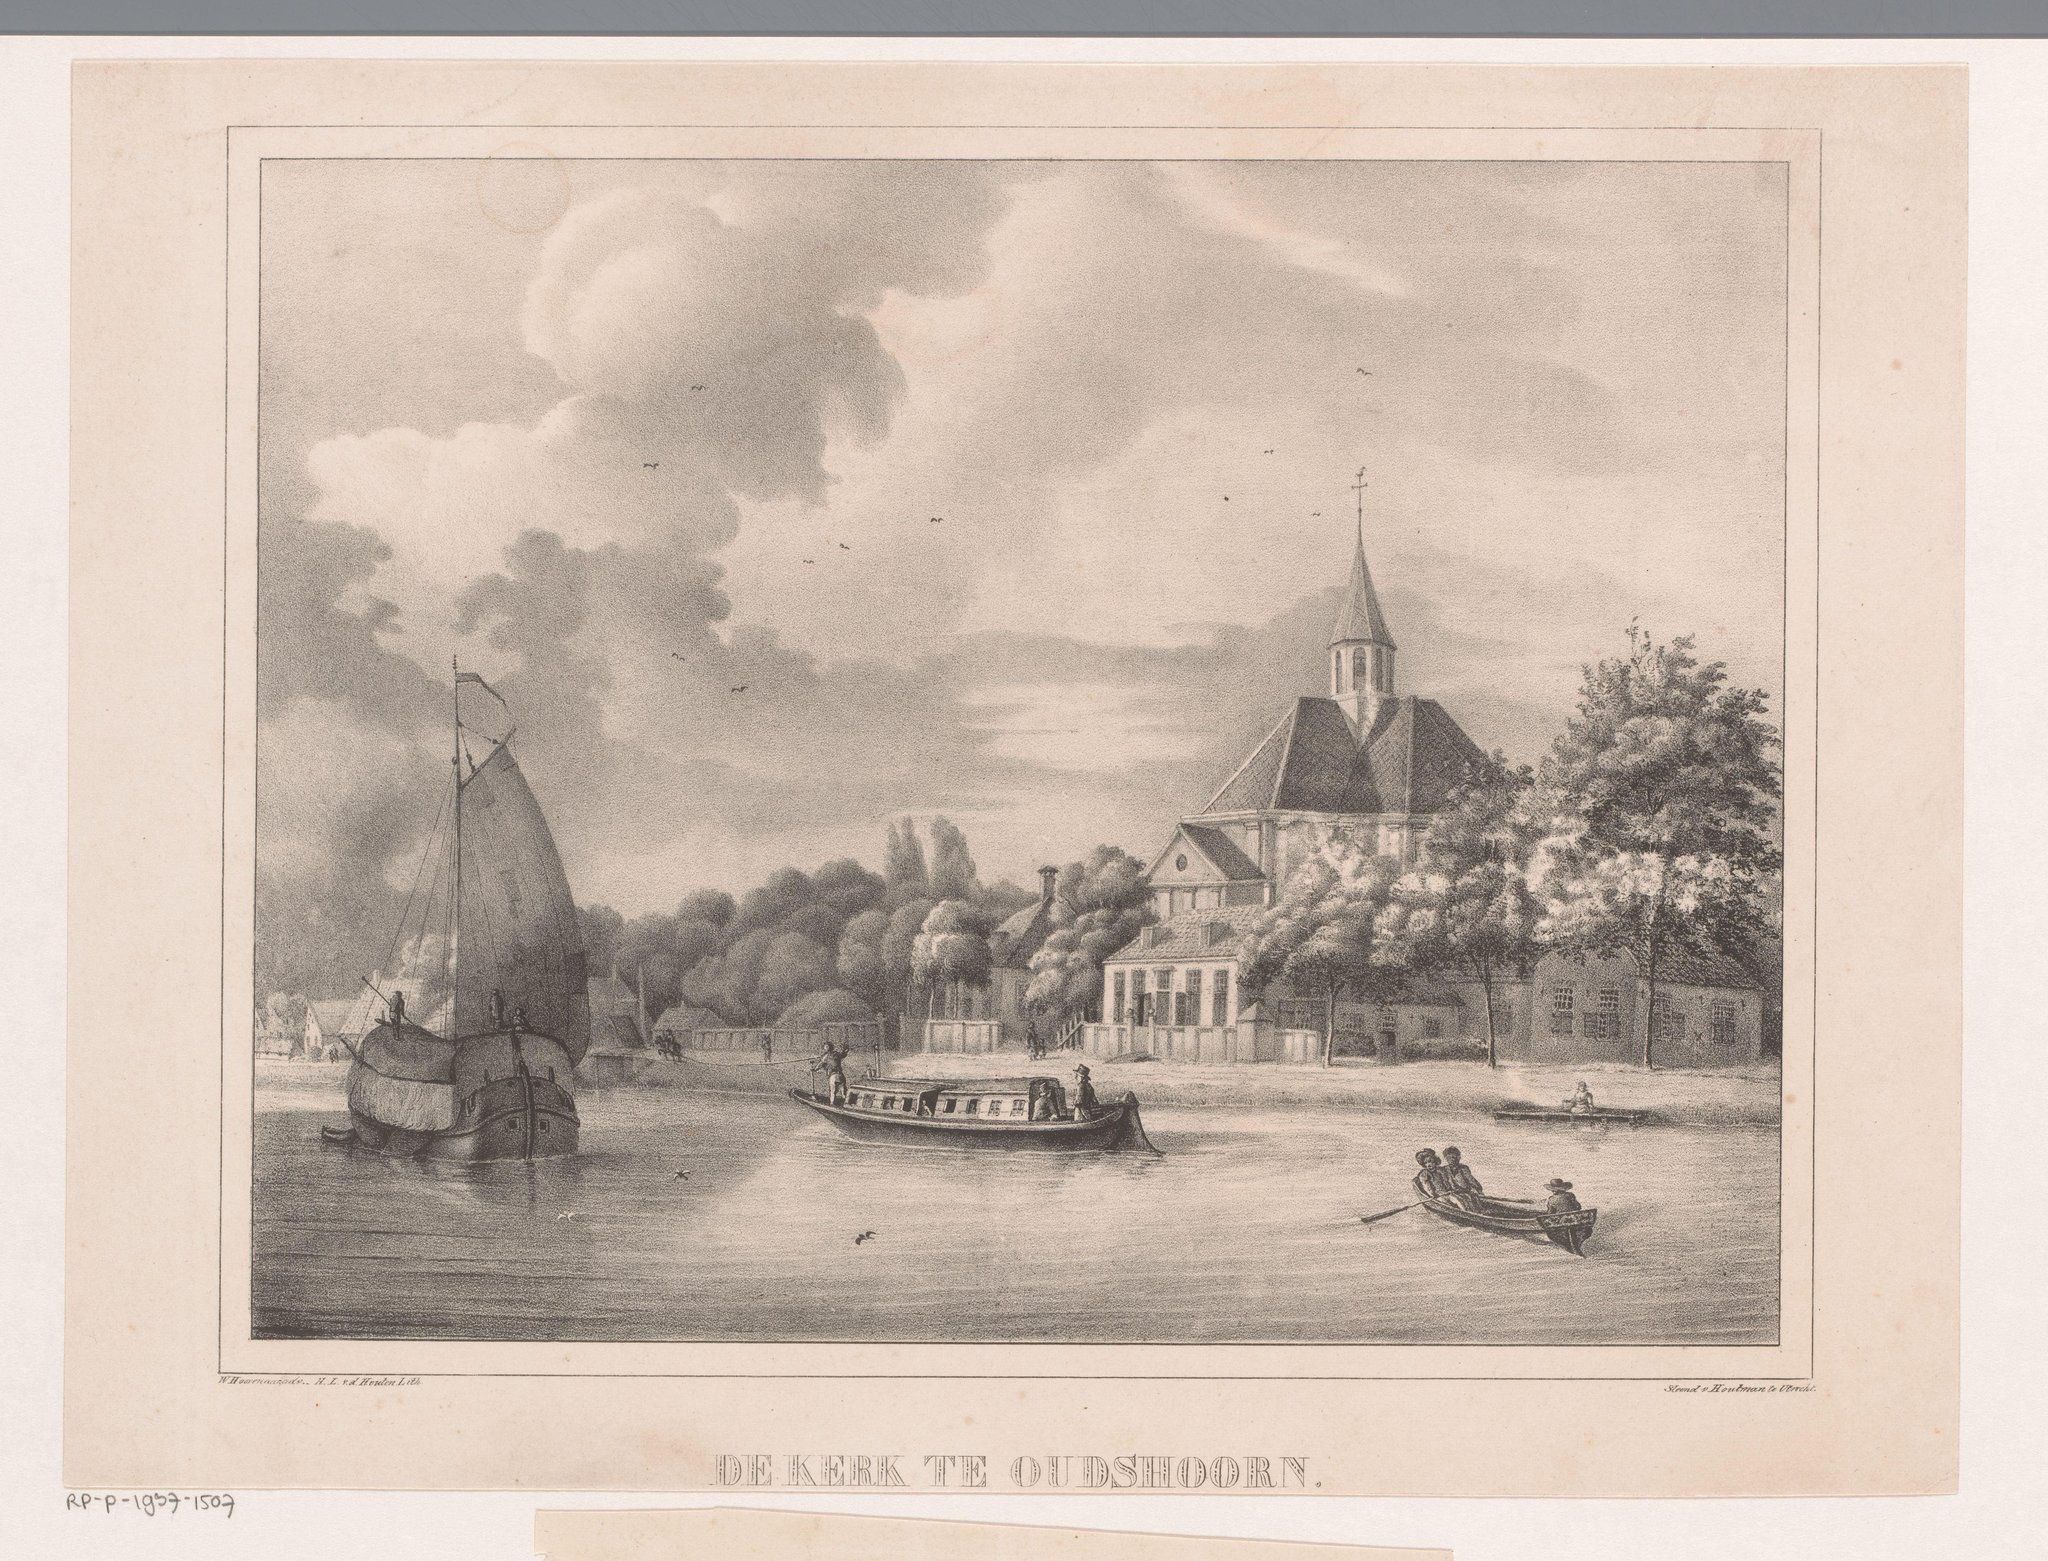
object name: print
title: De Kerk te Oudshoorn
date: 1828-1843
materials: paper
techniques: lithograph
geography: utrecht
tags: sailing-ship, sailing-boat, church (exterior), rowing facing backward, pulling, tow-boat, towing-barge, river (+ landscape with figures, staffage)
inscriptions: collector's mark: Lugt 2228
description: Op het water varen een trekschuit, een roei- en een zeilboot.